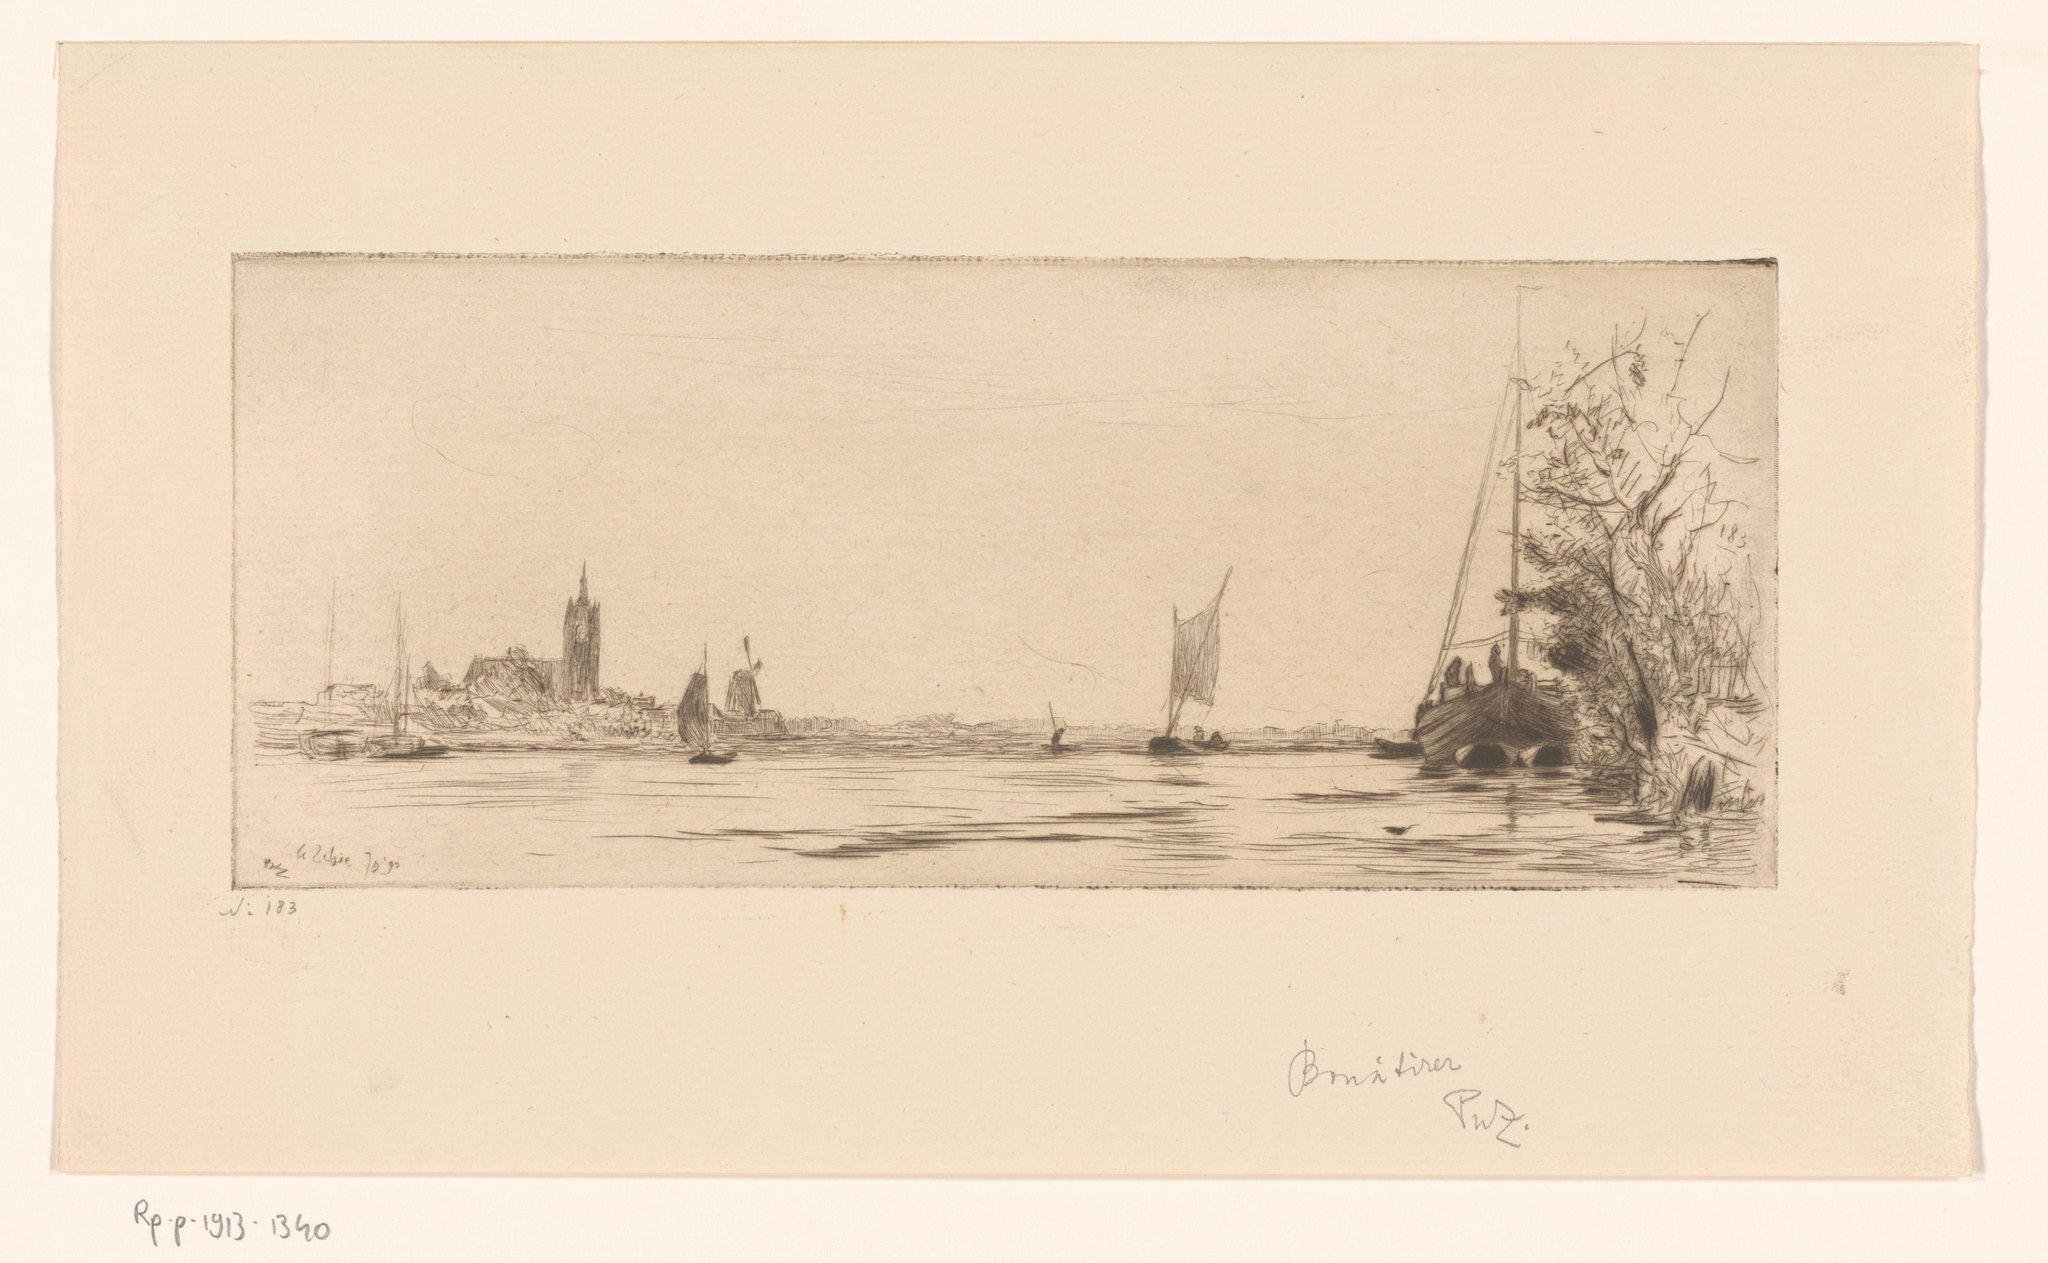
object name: print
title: Gezicht op de Schie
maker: philip zilcken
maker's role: draughtsman, painter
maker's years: 1857-1930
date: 1890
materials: paper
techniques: drypoint, intaglio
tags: sailing-ship, sailing-boat, city-view in general; 'veduta', river, delft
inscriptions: collector's mark: Lugt 2233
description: Op het water zeilboten. Linksachter de toren van de Oude Kerk van Delft.